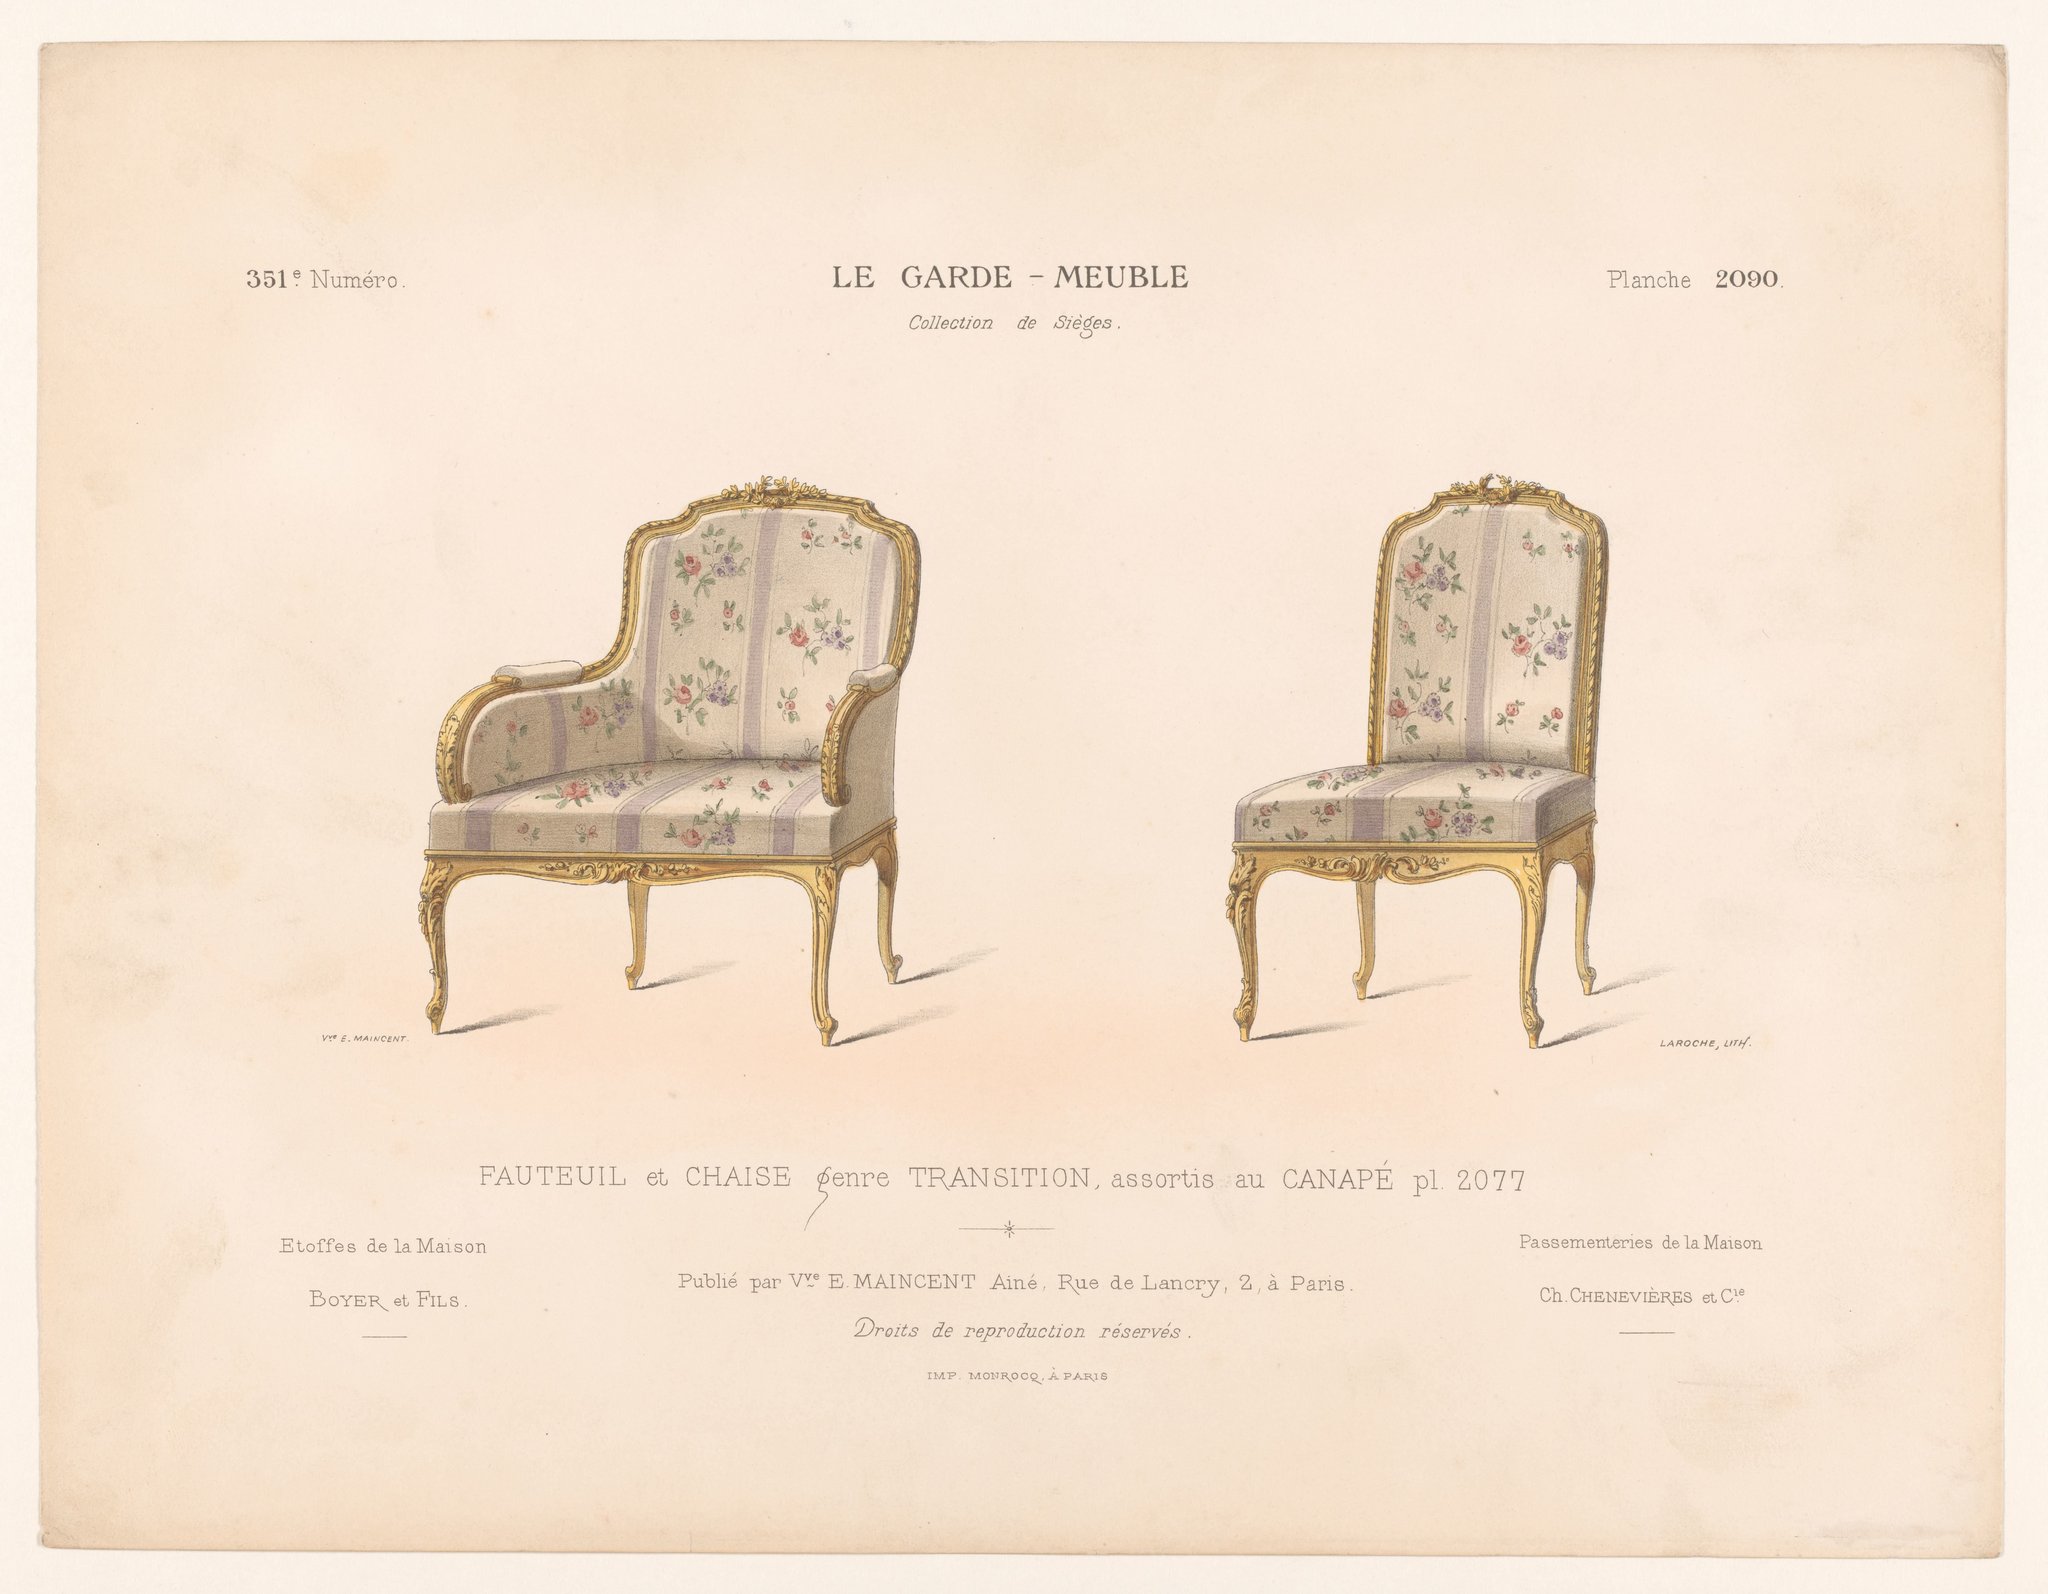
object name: print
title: Fauteuil en stoel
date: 1895-1935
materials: paper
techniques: hand coloring, lithograph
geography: paris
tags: seating furniture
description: Ieder Livraison in de serie Le Garde-Meuble bevat negen platen: drie 'sièges' (zitmeubels), drie 'meubles' (diverse meubels zoals tafels en kasten) en drie 'tentures' (gordijnen en draperieën).